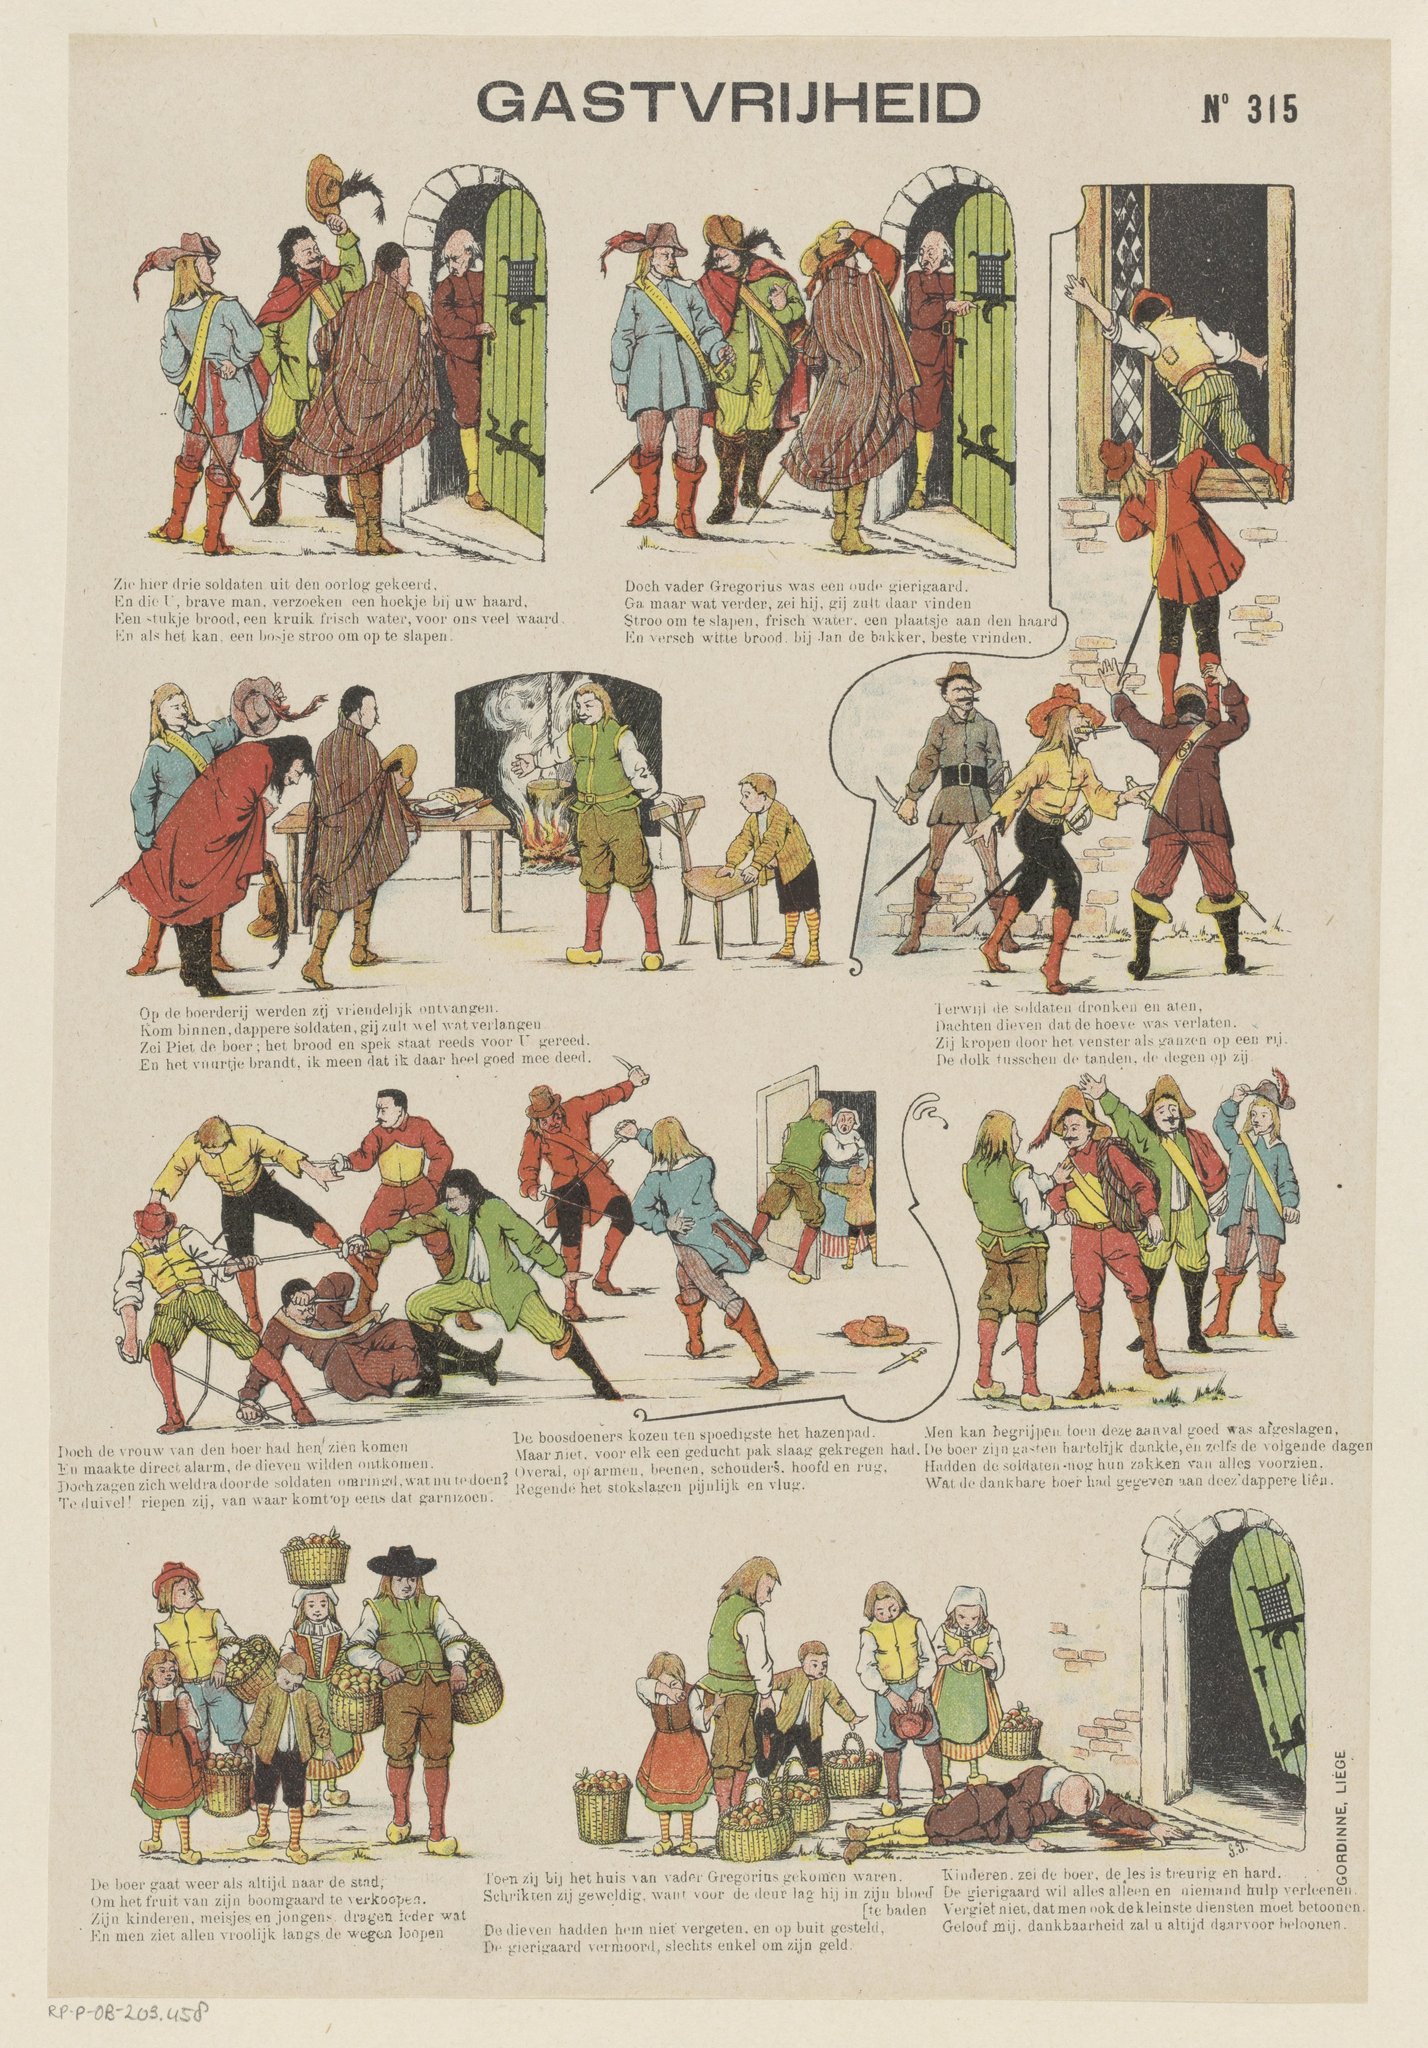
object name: print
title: Gastvrijheid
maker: monogrammist g.j.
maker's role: print maker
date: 1894-1959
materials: paper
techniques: lithograph, letterpress printing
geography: liège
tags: hospitality; 'hospitalità' (ripa), robber, murder, the soldier; the soldier's life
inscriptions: collector's mark: Lugt 2760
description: Blad met 8 voorstellingen over drie soldaten die gastvrij worden ontvangen bij boer Piet, nadat de gierigaard vader Gregorius ze de deur had gewezen. Onder elke afbeelding een onderschrift. Genummerd rechtsboven: No 315.